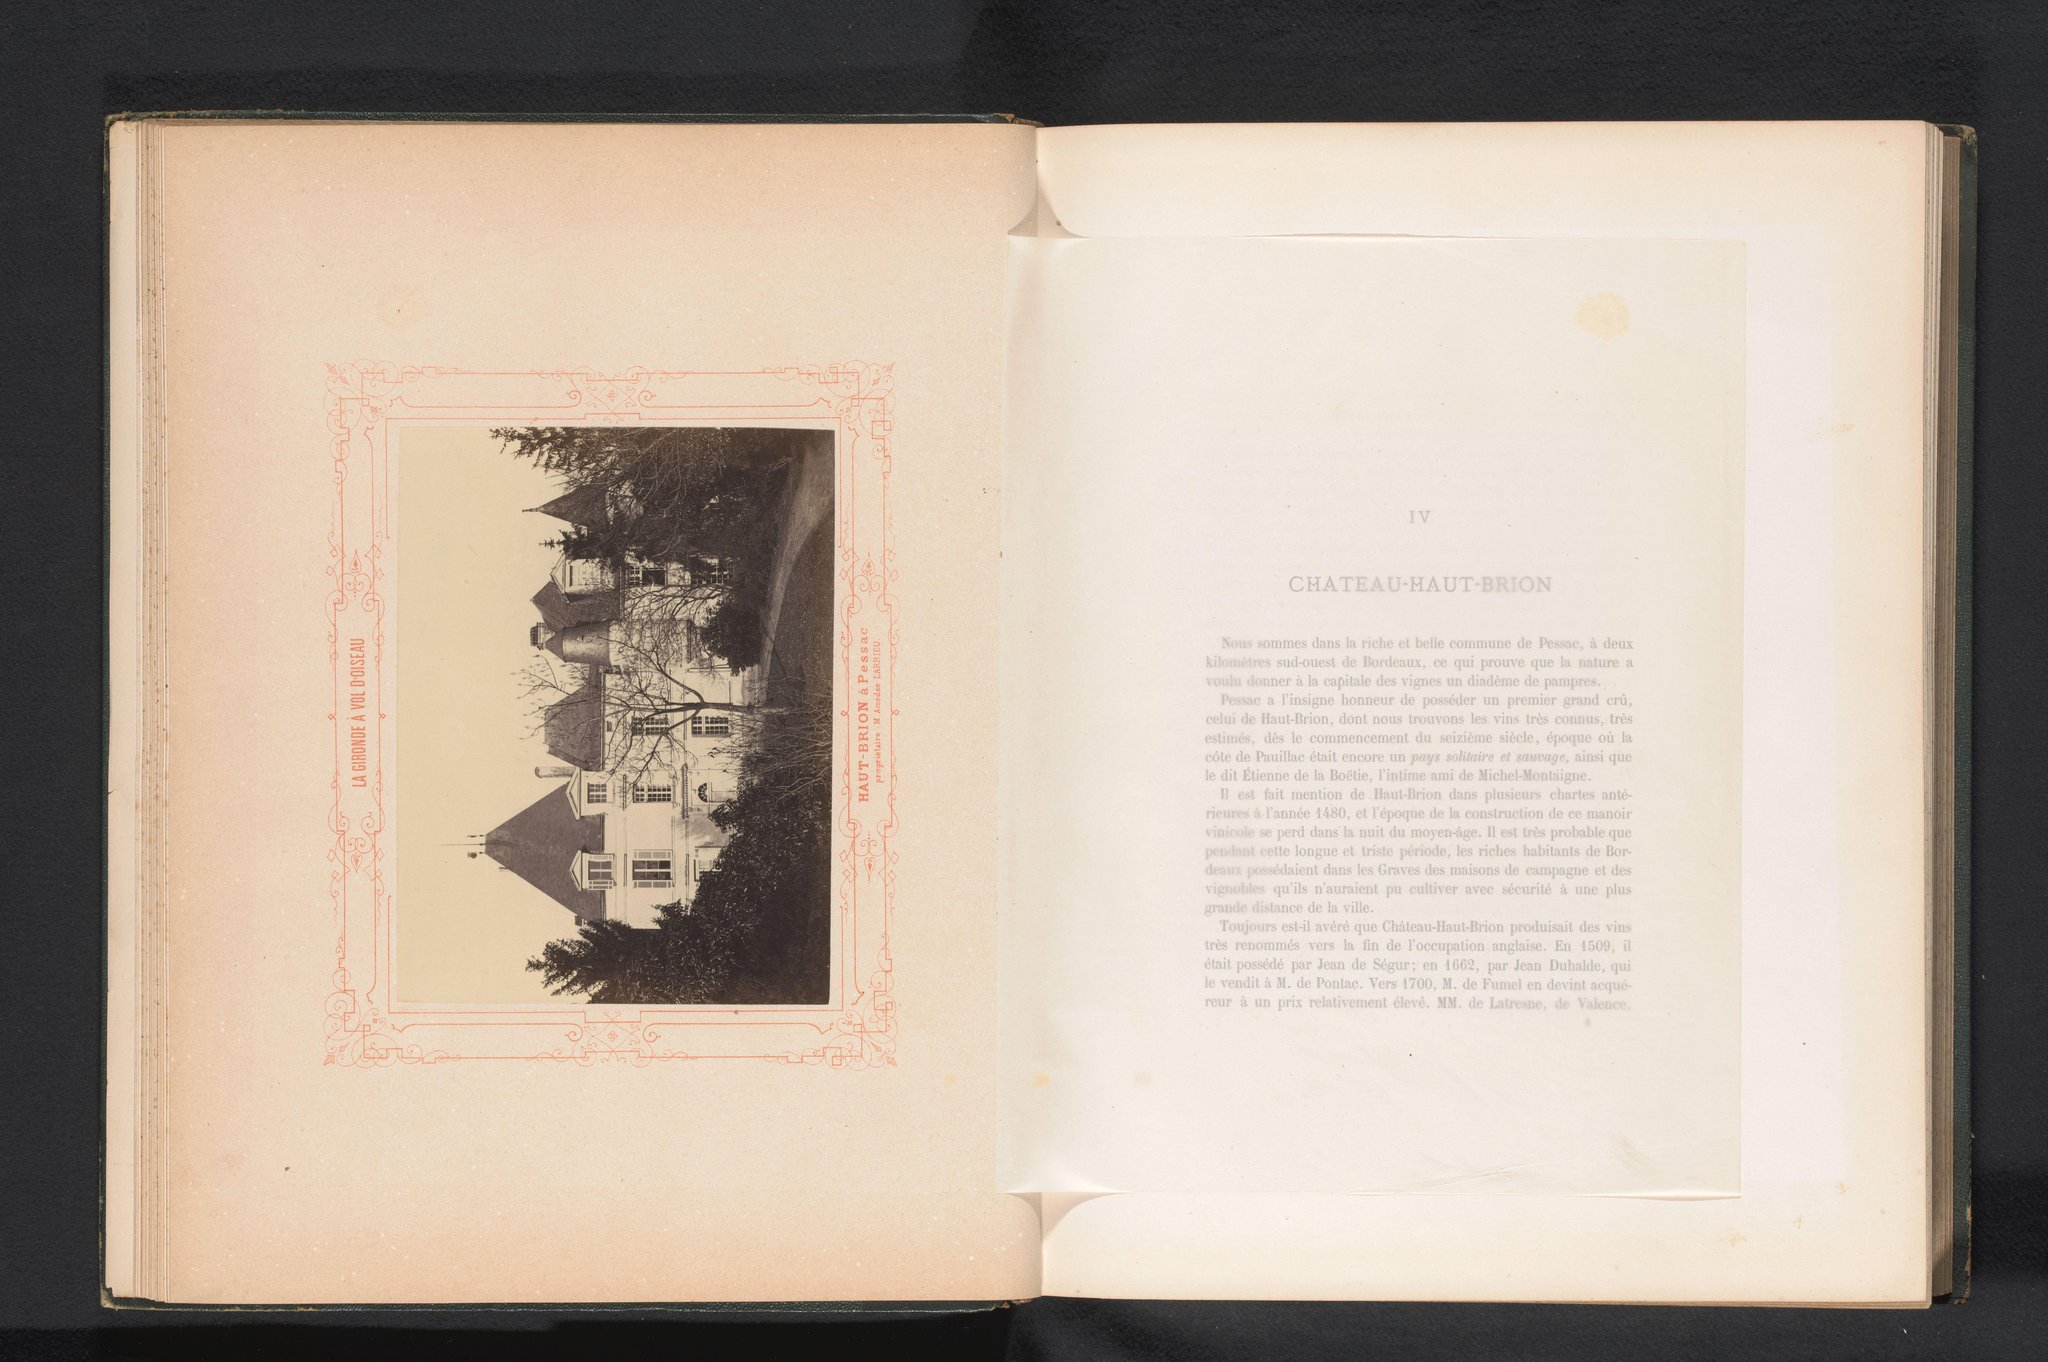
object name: photograph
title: Haut-Brion à Pessac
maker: alfred danflou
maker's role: fotograaf, schrijver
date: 1862-1867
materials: photographic support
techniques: albumen print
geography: pessac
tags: castle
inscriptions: inscription: ‘propriétaire: M. Amédée LARRIEU.’